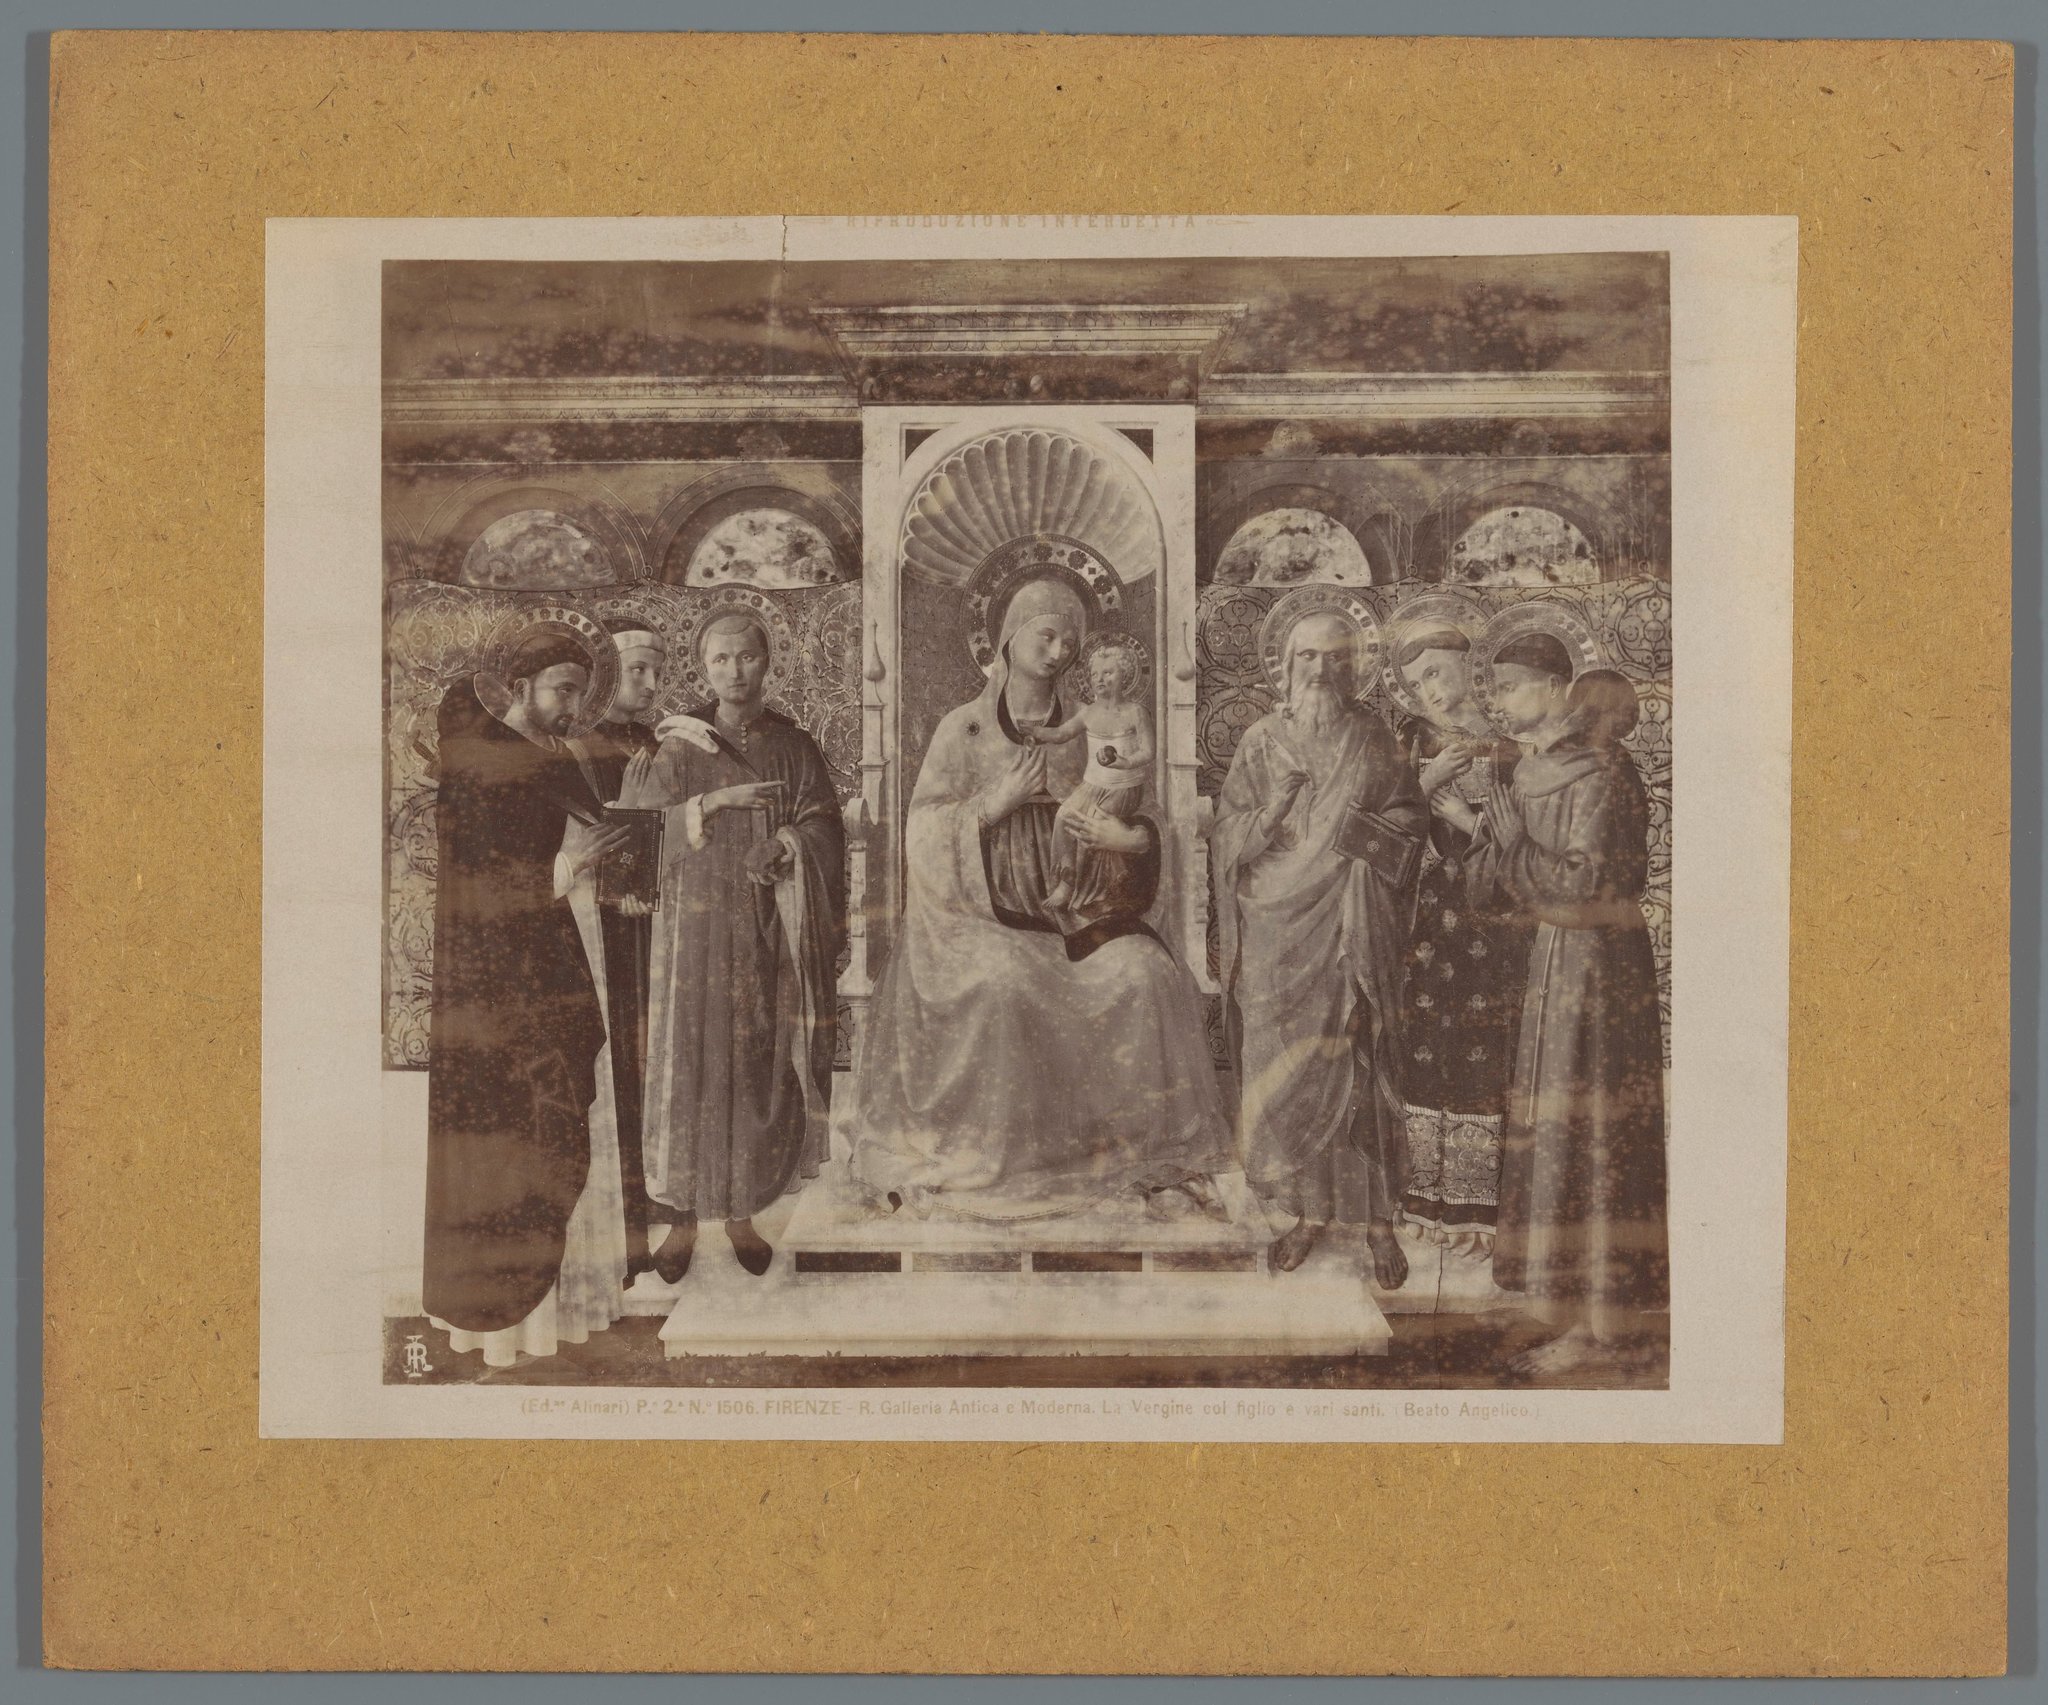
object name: reproduction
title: FIRENZE - R. Galleria Antica e Moderna. La Vergine col figlio e vari santi.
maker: fra angelico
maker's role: painter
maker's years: 1400-1455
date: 1875-1900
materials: cardboard, photographic support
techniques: albumen print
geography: galleria dell'accademia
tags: madonna: mary sitting or enthroned, the christ-child in her lap (or in front of her bosom) (mary sometimes represented half-length), saints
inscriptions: collector's mark: Lugt 3937, inscription:, number: ‘P.e 2.a N.o 1506.’